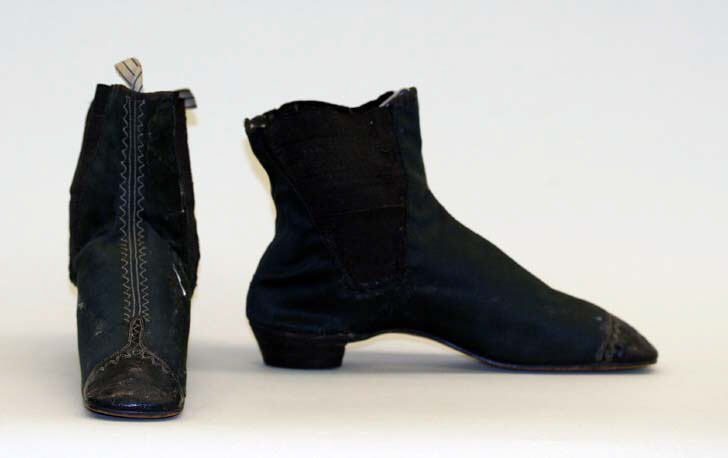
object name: boot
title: Boots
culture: american or european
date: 1860-1869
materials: leather